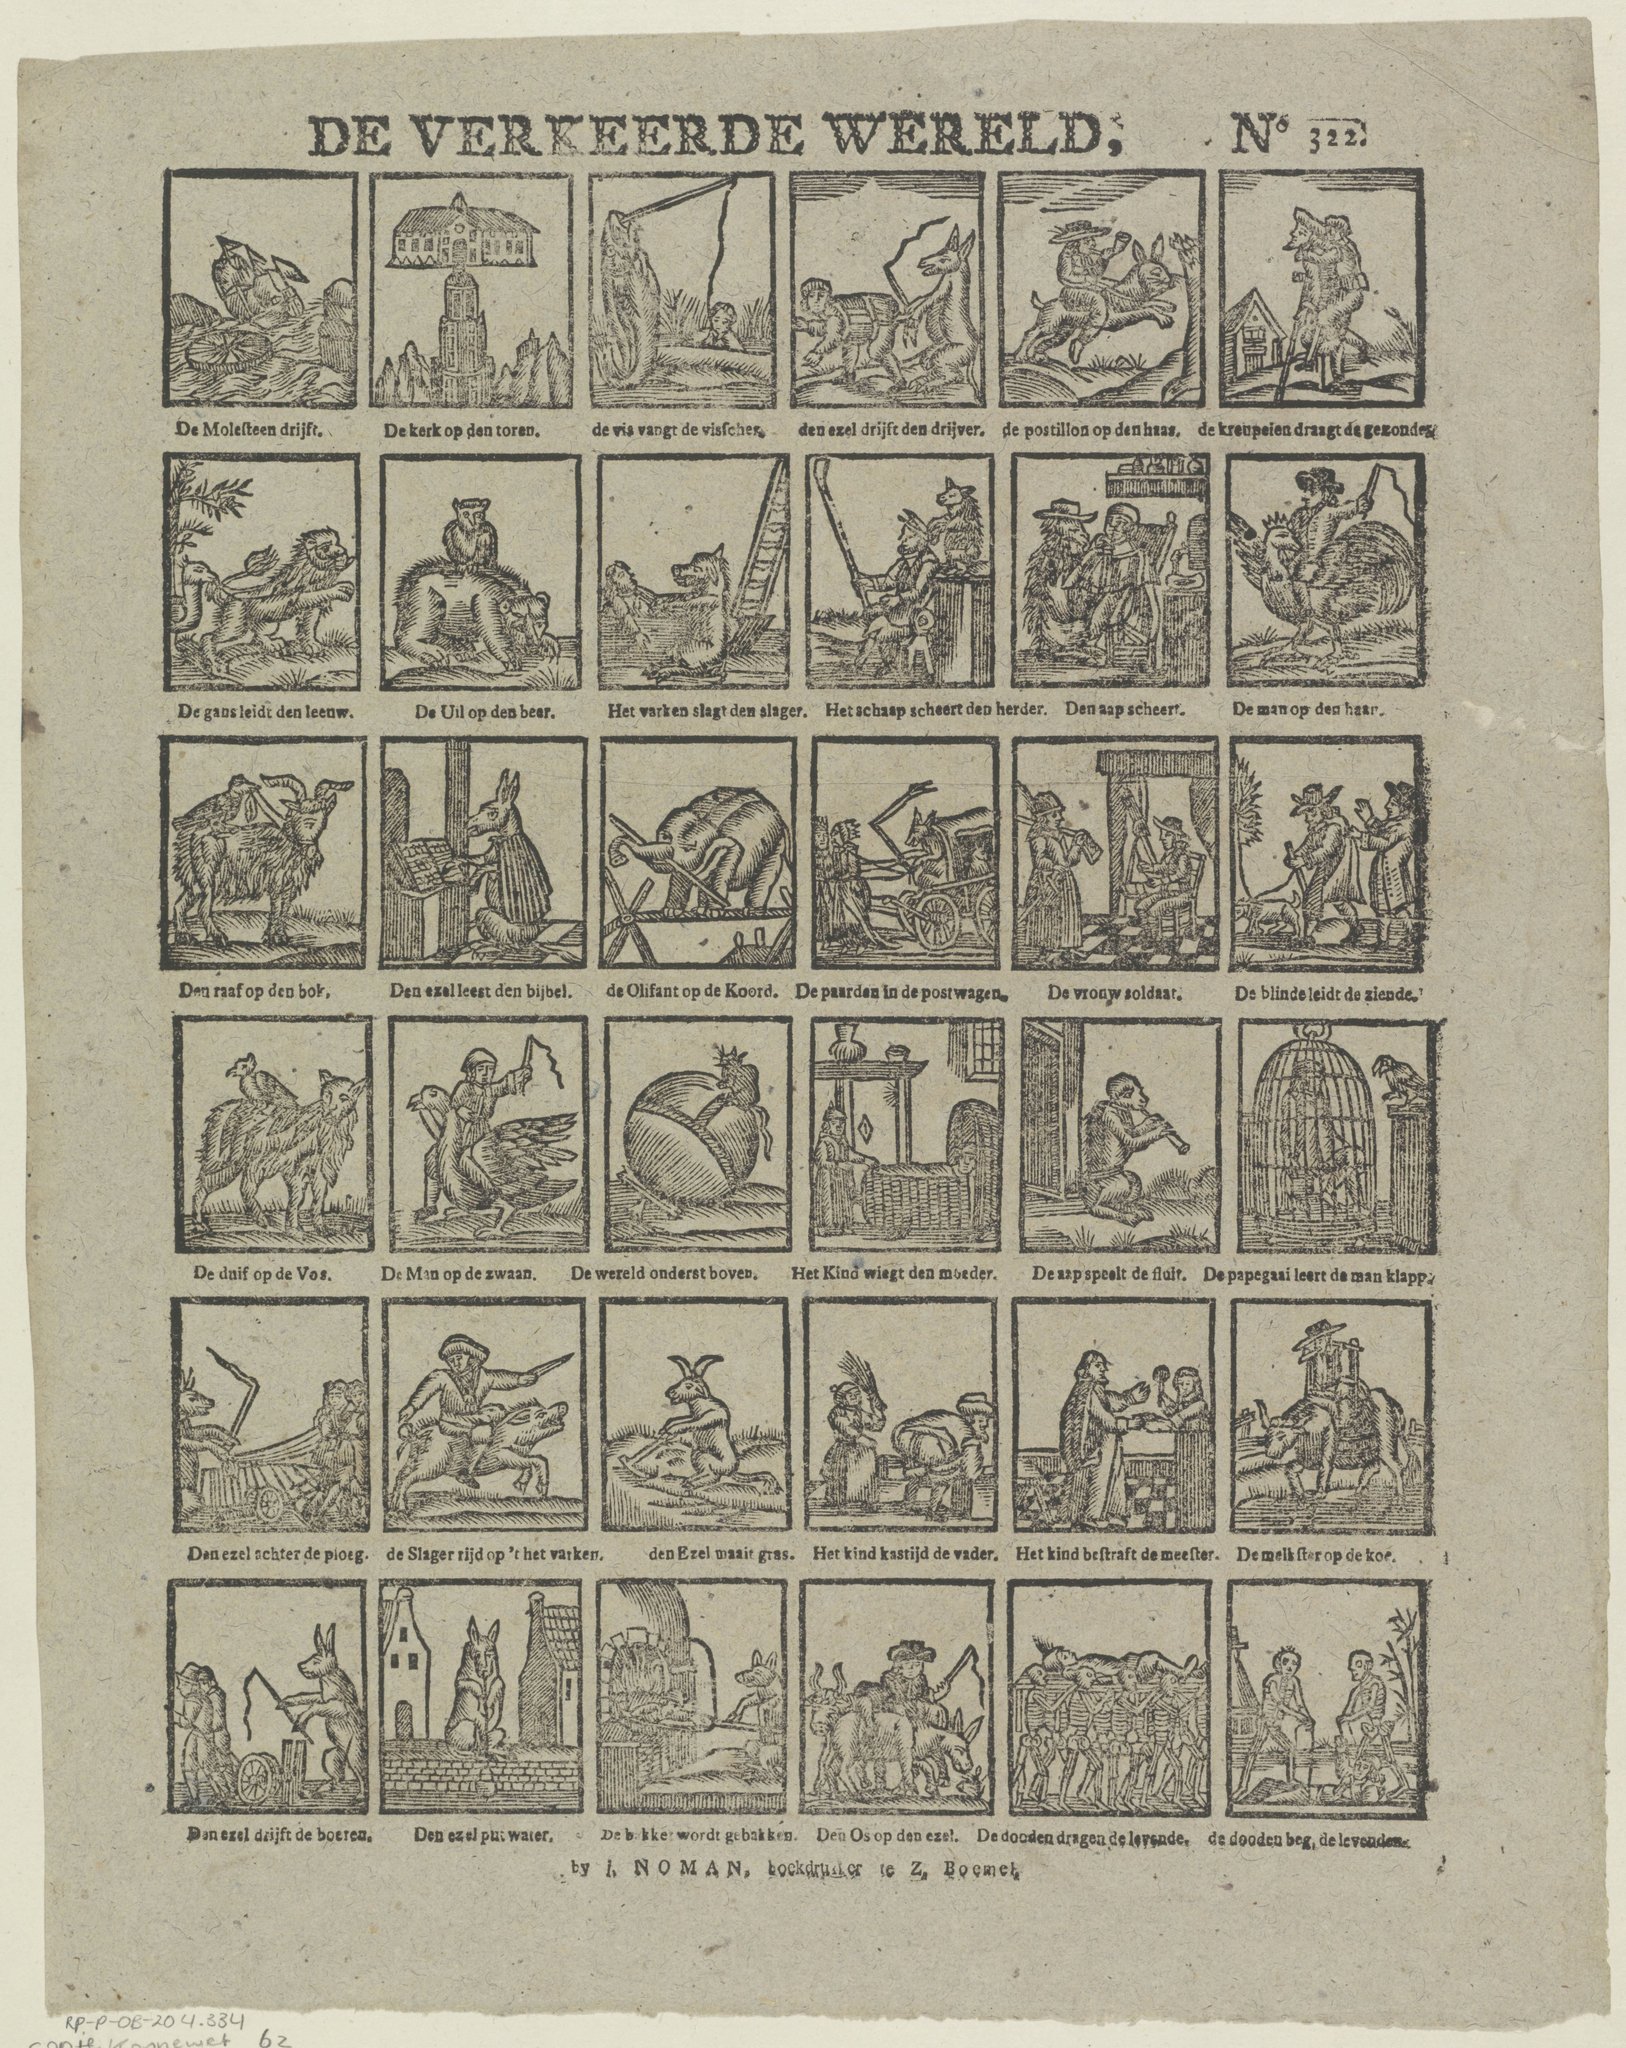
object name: popular print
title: De verkeerde wereld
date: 1806-1830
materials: paper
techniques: letterpress printing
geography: zaltbommel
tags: 'mundus inversus', the reversed world, the topsy-turvy world, 'le monde bestourné', animals acting as human beings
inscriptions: collector's mark: Lugt 2760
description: Blad met 36 voorstellingen van de verkeerde wereld, waar onder andere dieren zich als mensen gedragen. Onder elke afbeelding een onderschrift. Genummerd rechtsboven: No. 322.